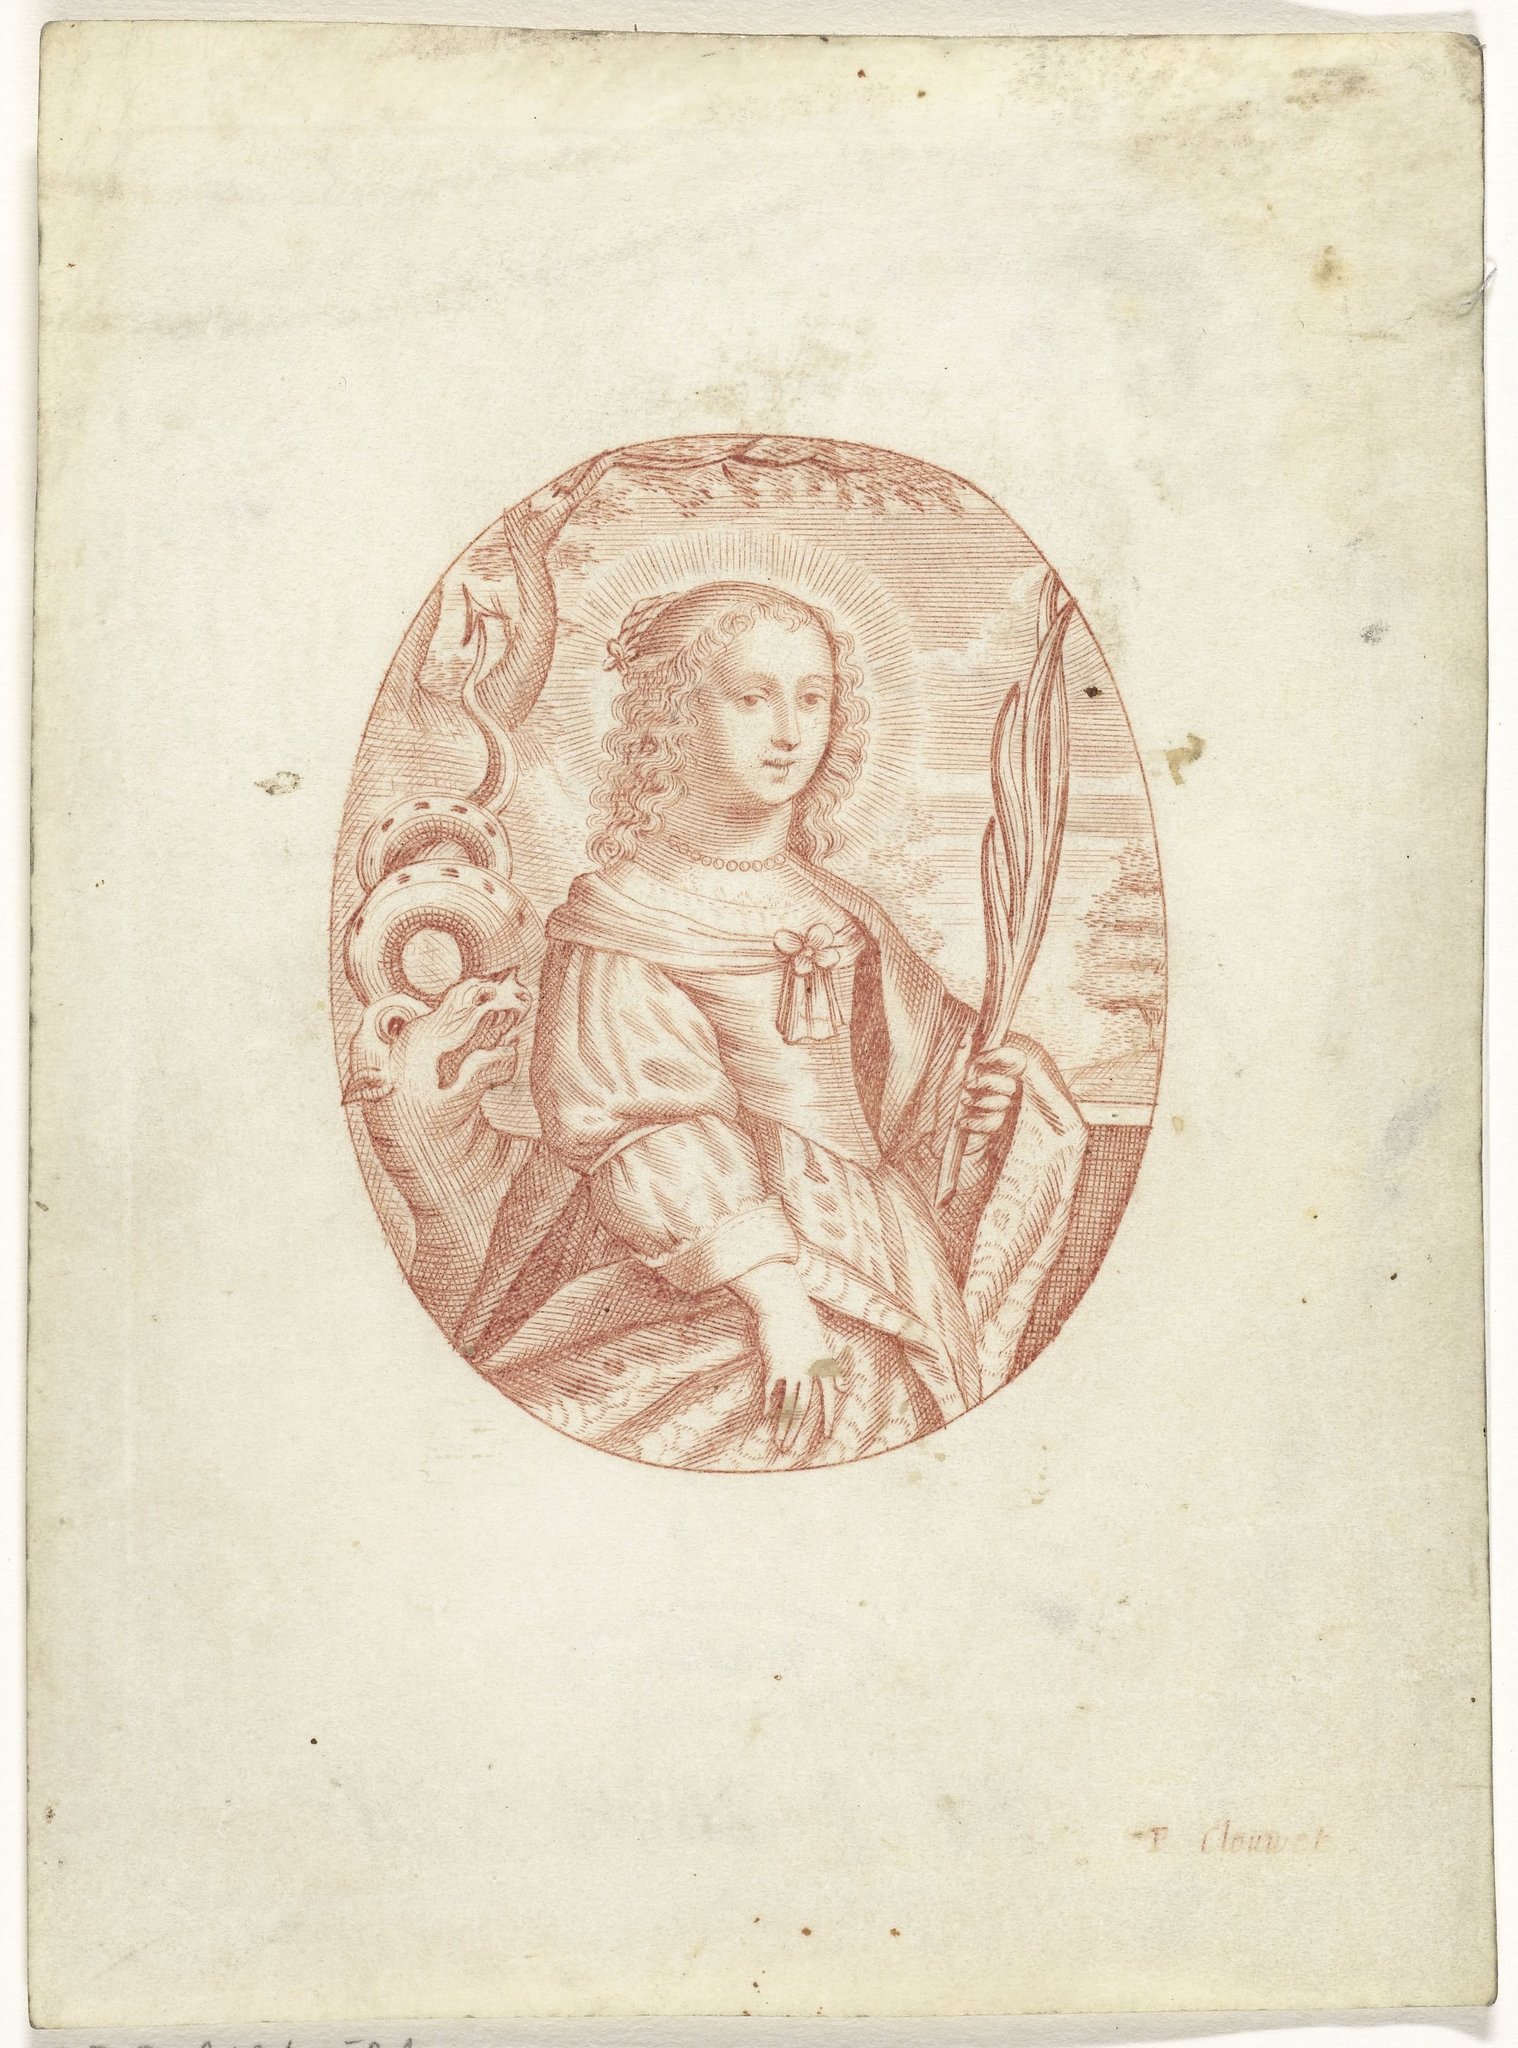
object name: print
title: Heilige Margaretha als martelares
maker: petrus clouwet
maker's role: draughtsman, print maker, publisher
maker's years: 1629-1670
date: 1639-1670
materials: parchment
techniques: engraving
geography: antwerp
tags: martyrdom, suffering, misfortune, death of st. margaret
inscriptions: inscription: ‘Elck huysken heeft zijn kruijsken en isser godts kruijsken niet soo en isset godts huijsken niet sonder verdriet en deughen wij niet’, inscription: ‘Dit prentje heb ik gekregen van de vrouw van At Alkmaar de 16 Januari 1695’, collector's mark: Lugt 2228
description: De Heilige Margaretha met palmtak in de hand; linksachter haar de draak. In ovaal. Gebruikt als bidprentje. Op perkament. Met annotatie en gedicht op achterkant: Elck huysken heeft sijn kruijsken....